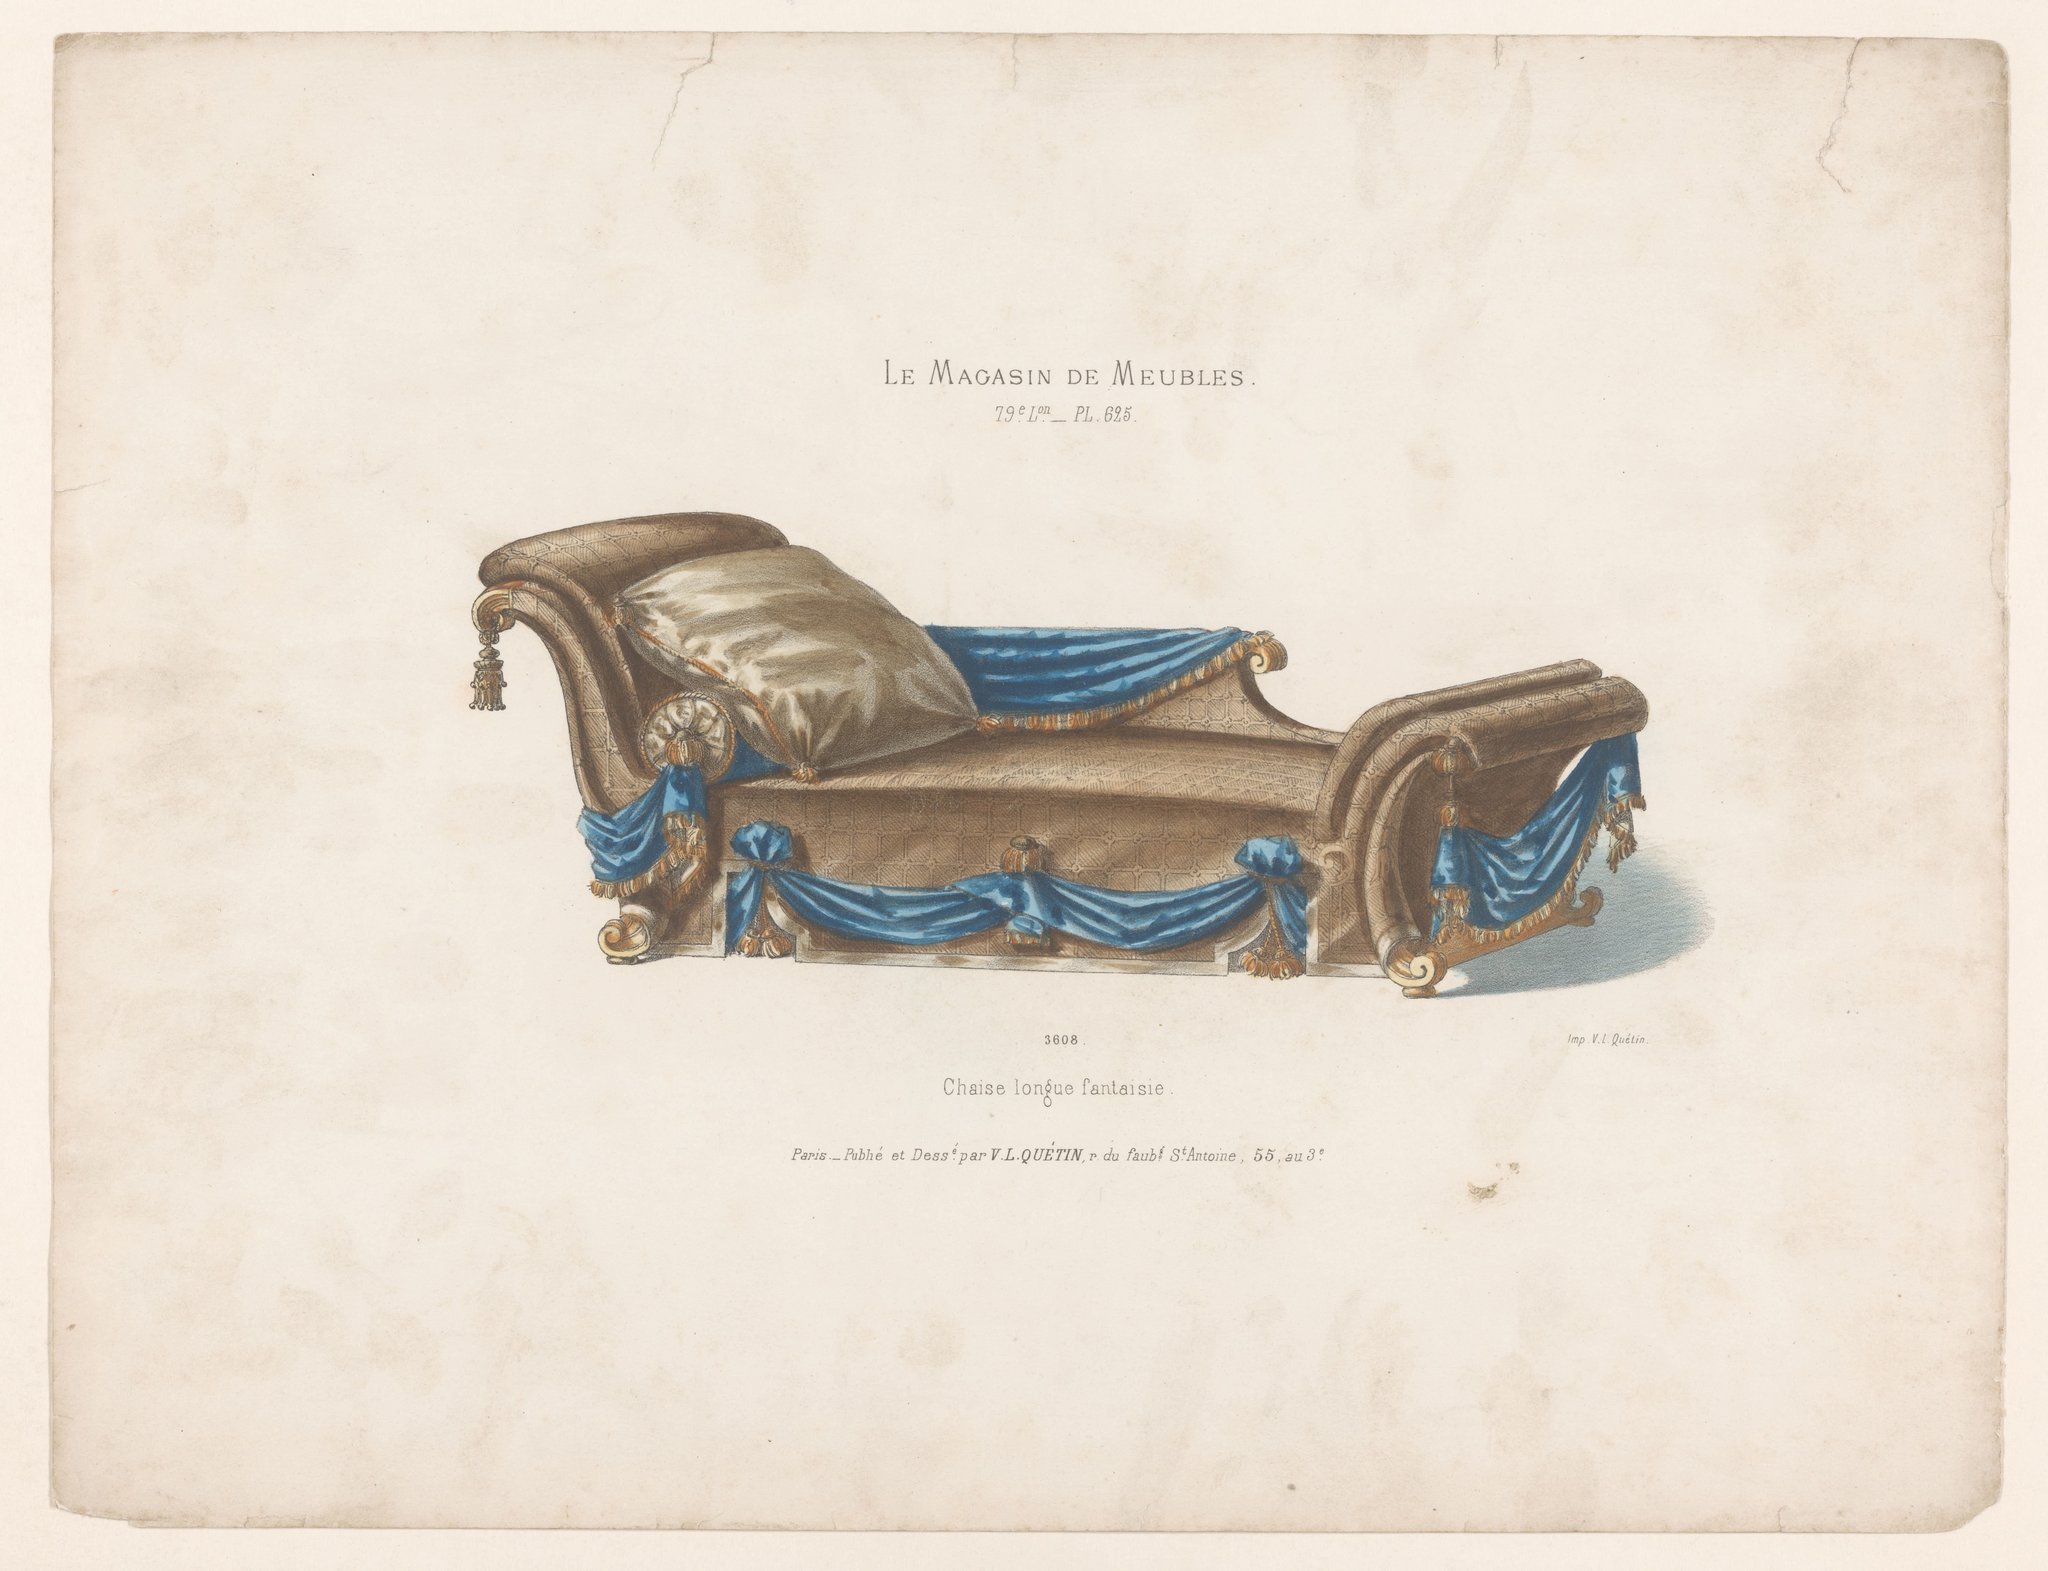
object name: print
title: Chaise longue fantaisie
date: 1878-1904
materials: paper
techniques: hand coloring, lithograph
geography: paris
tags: seating furniture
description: Een chaise longue. Prent uit 79e Livraison.